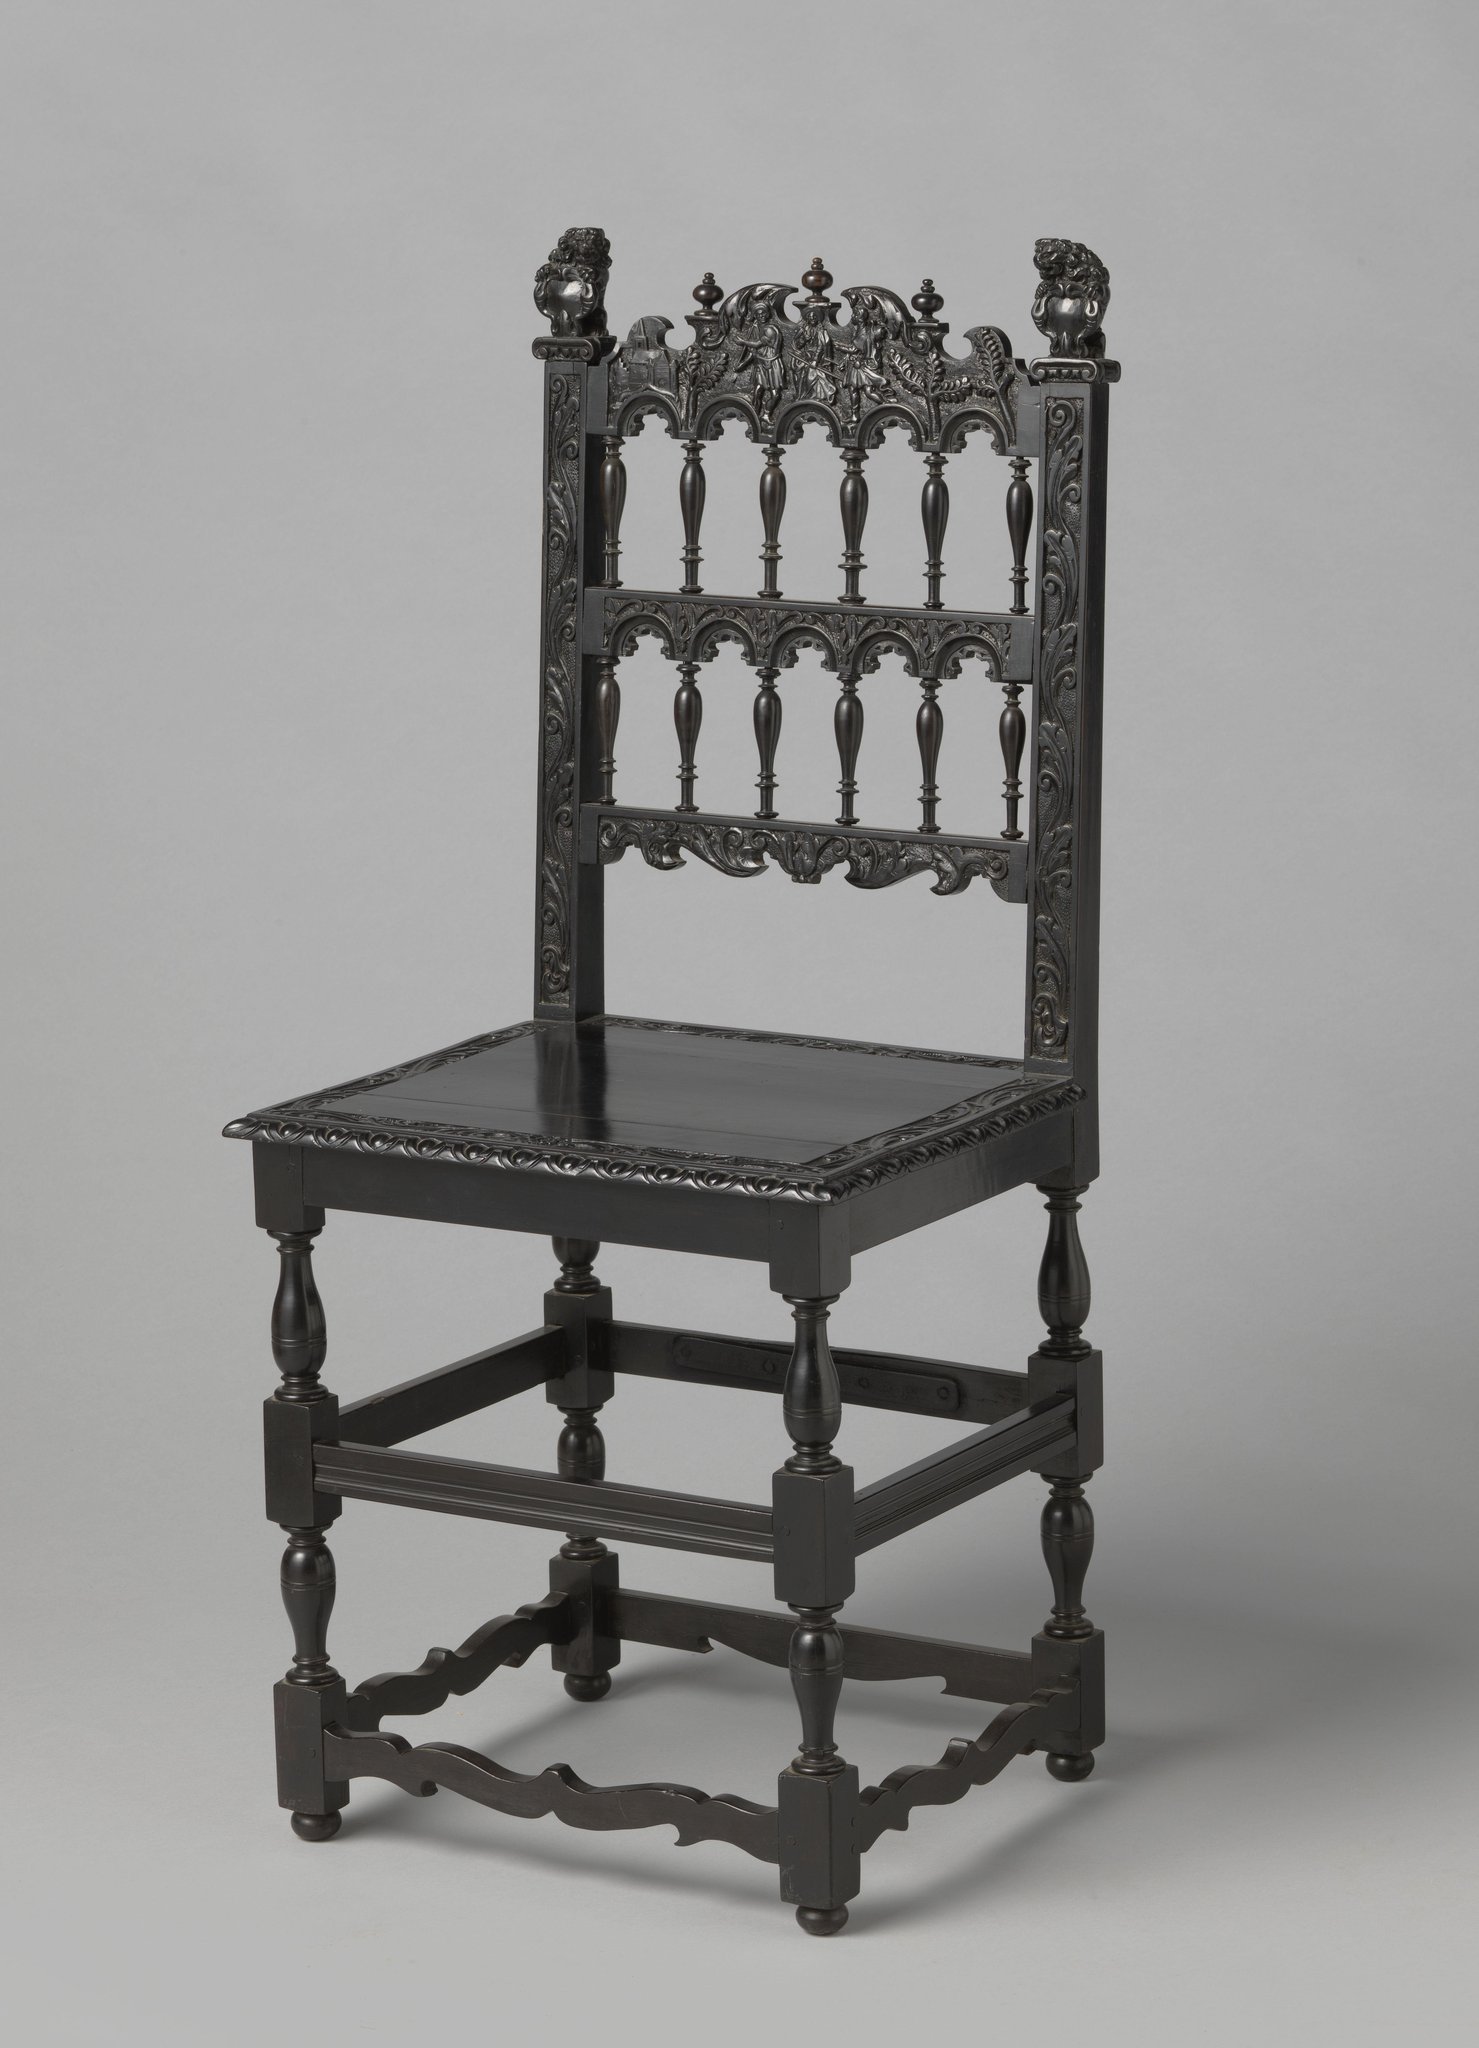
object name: seating furniture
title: Stoel van ebbenhout met Emmaüsgangers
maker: Anonymous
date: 1600-1650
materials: wood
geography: northern netherlands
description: Stoel van ebbenhout. De poten met huis en geleding worden door accoladevormige en rechte sporten verbonden. De vierkante zitting steekt aan drie kanten over met een profiel met eierlijst, rondom de zitting gestoken bladranken. De rugstijlen met gesneden bladranken dragen een staande leeuw met schild. De drie boogvormige en geschulpte sporten zijn verbonden door balusters. De onderste twee tonen bladwerk en de bovendorpel een gesneden voorstelling van de en drie gedraaide vaasjes.